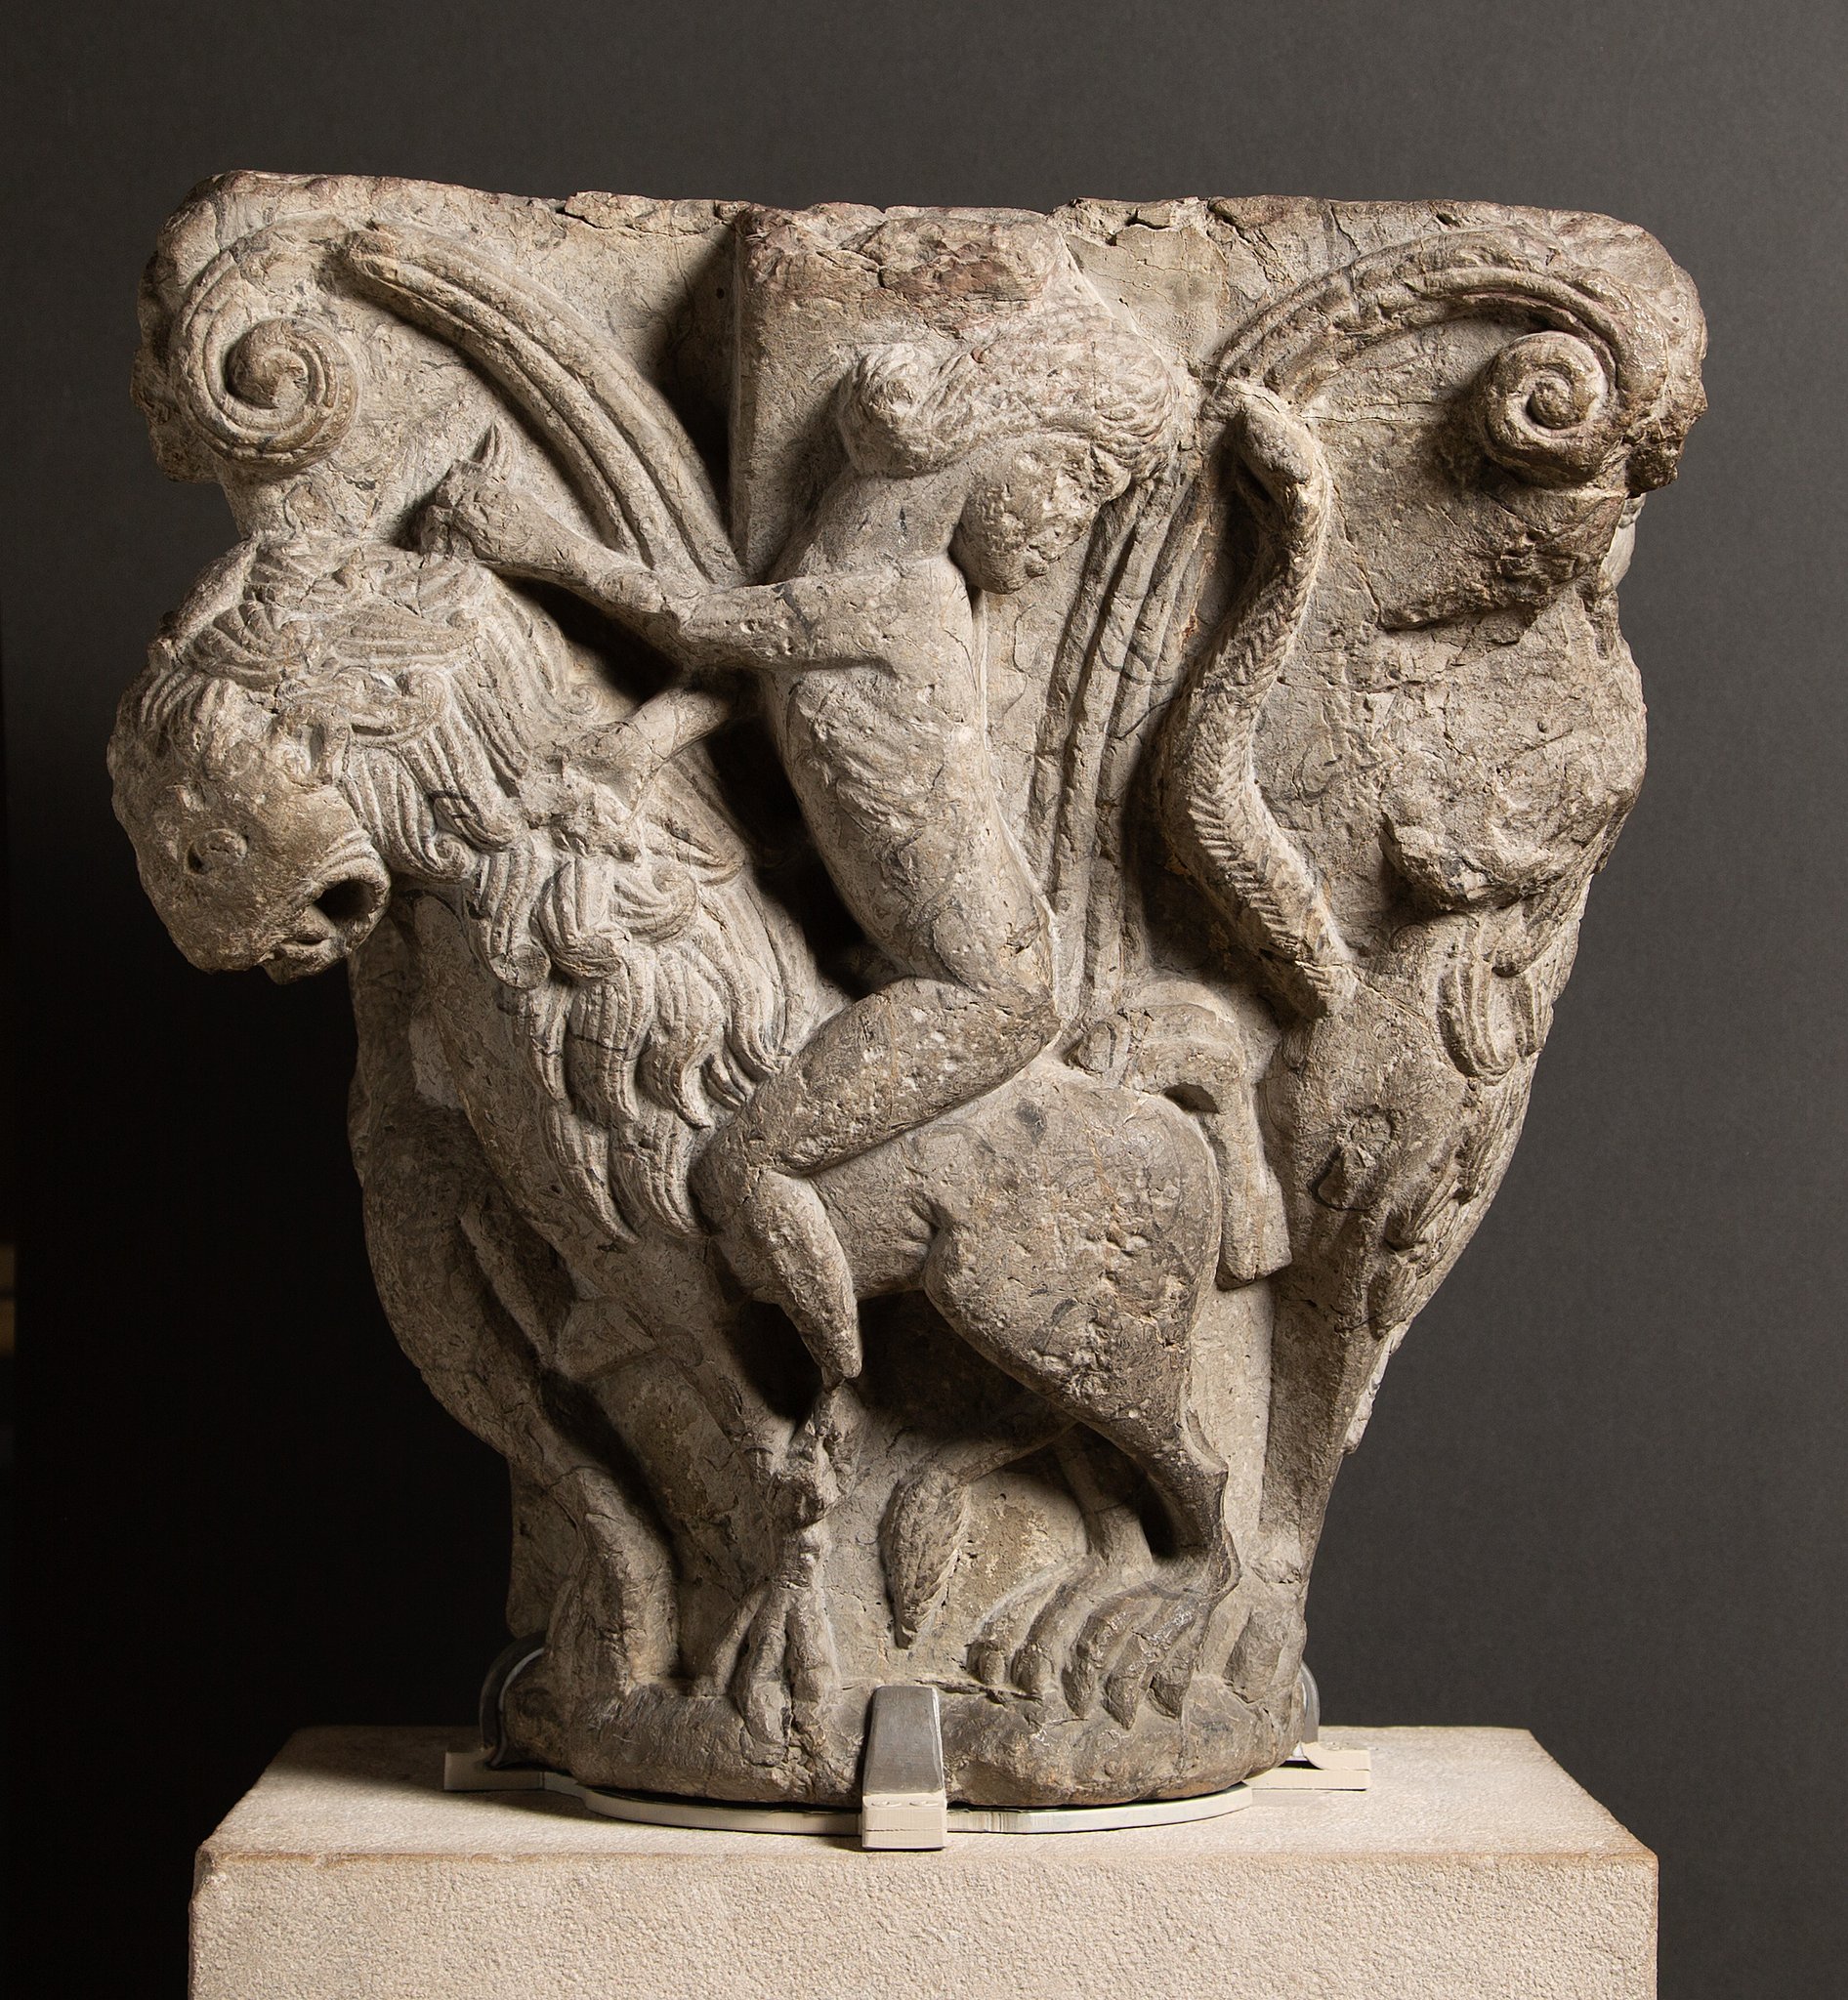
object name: capital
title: Capital with Lions Mounted by Nude Riders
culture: french or spanish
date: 1101-1150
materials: stone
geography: spain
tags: male nudes,lions